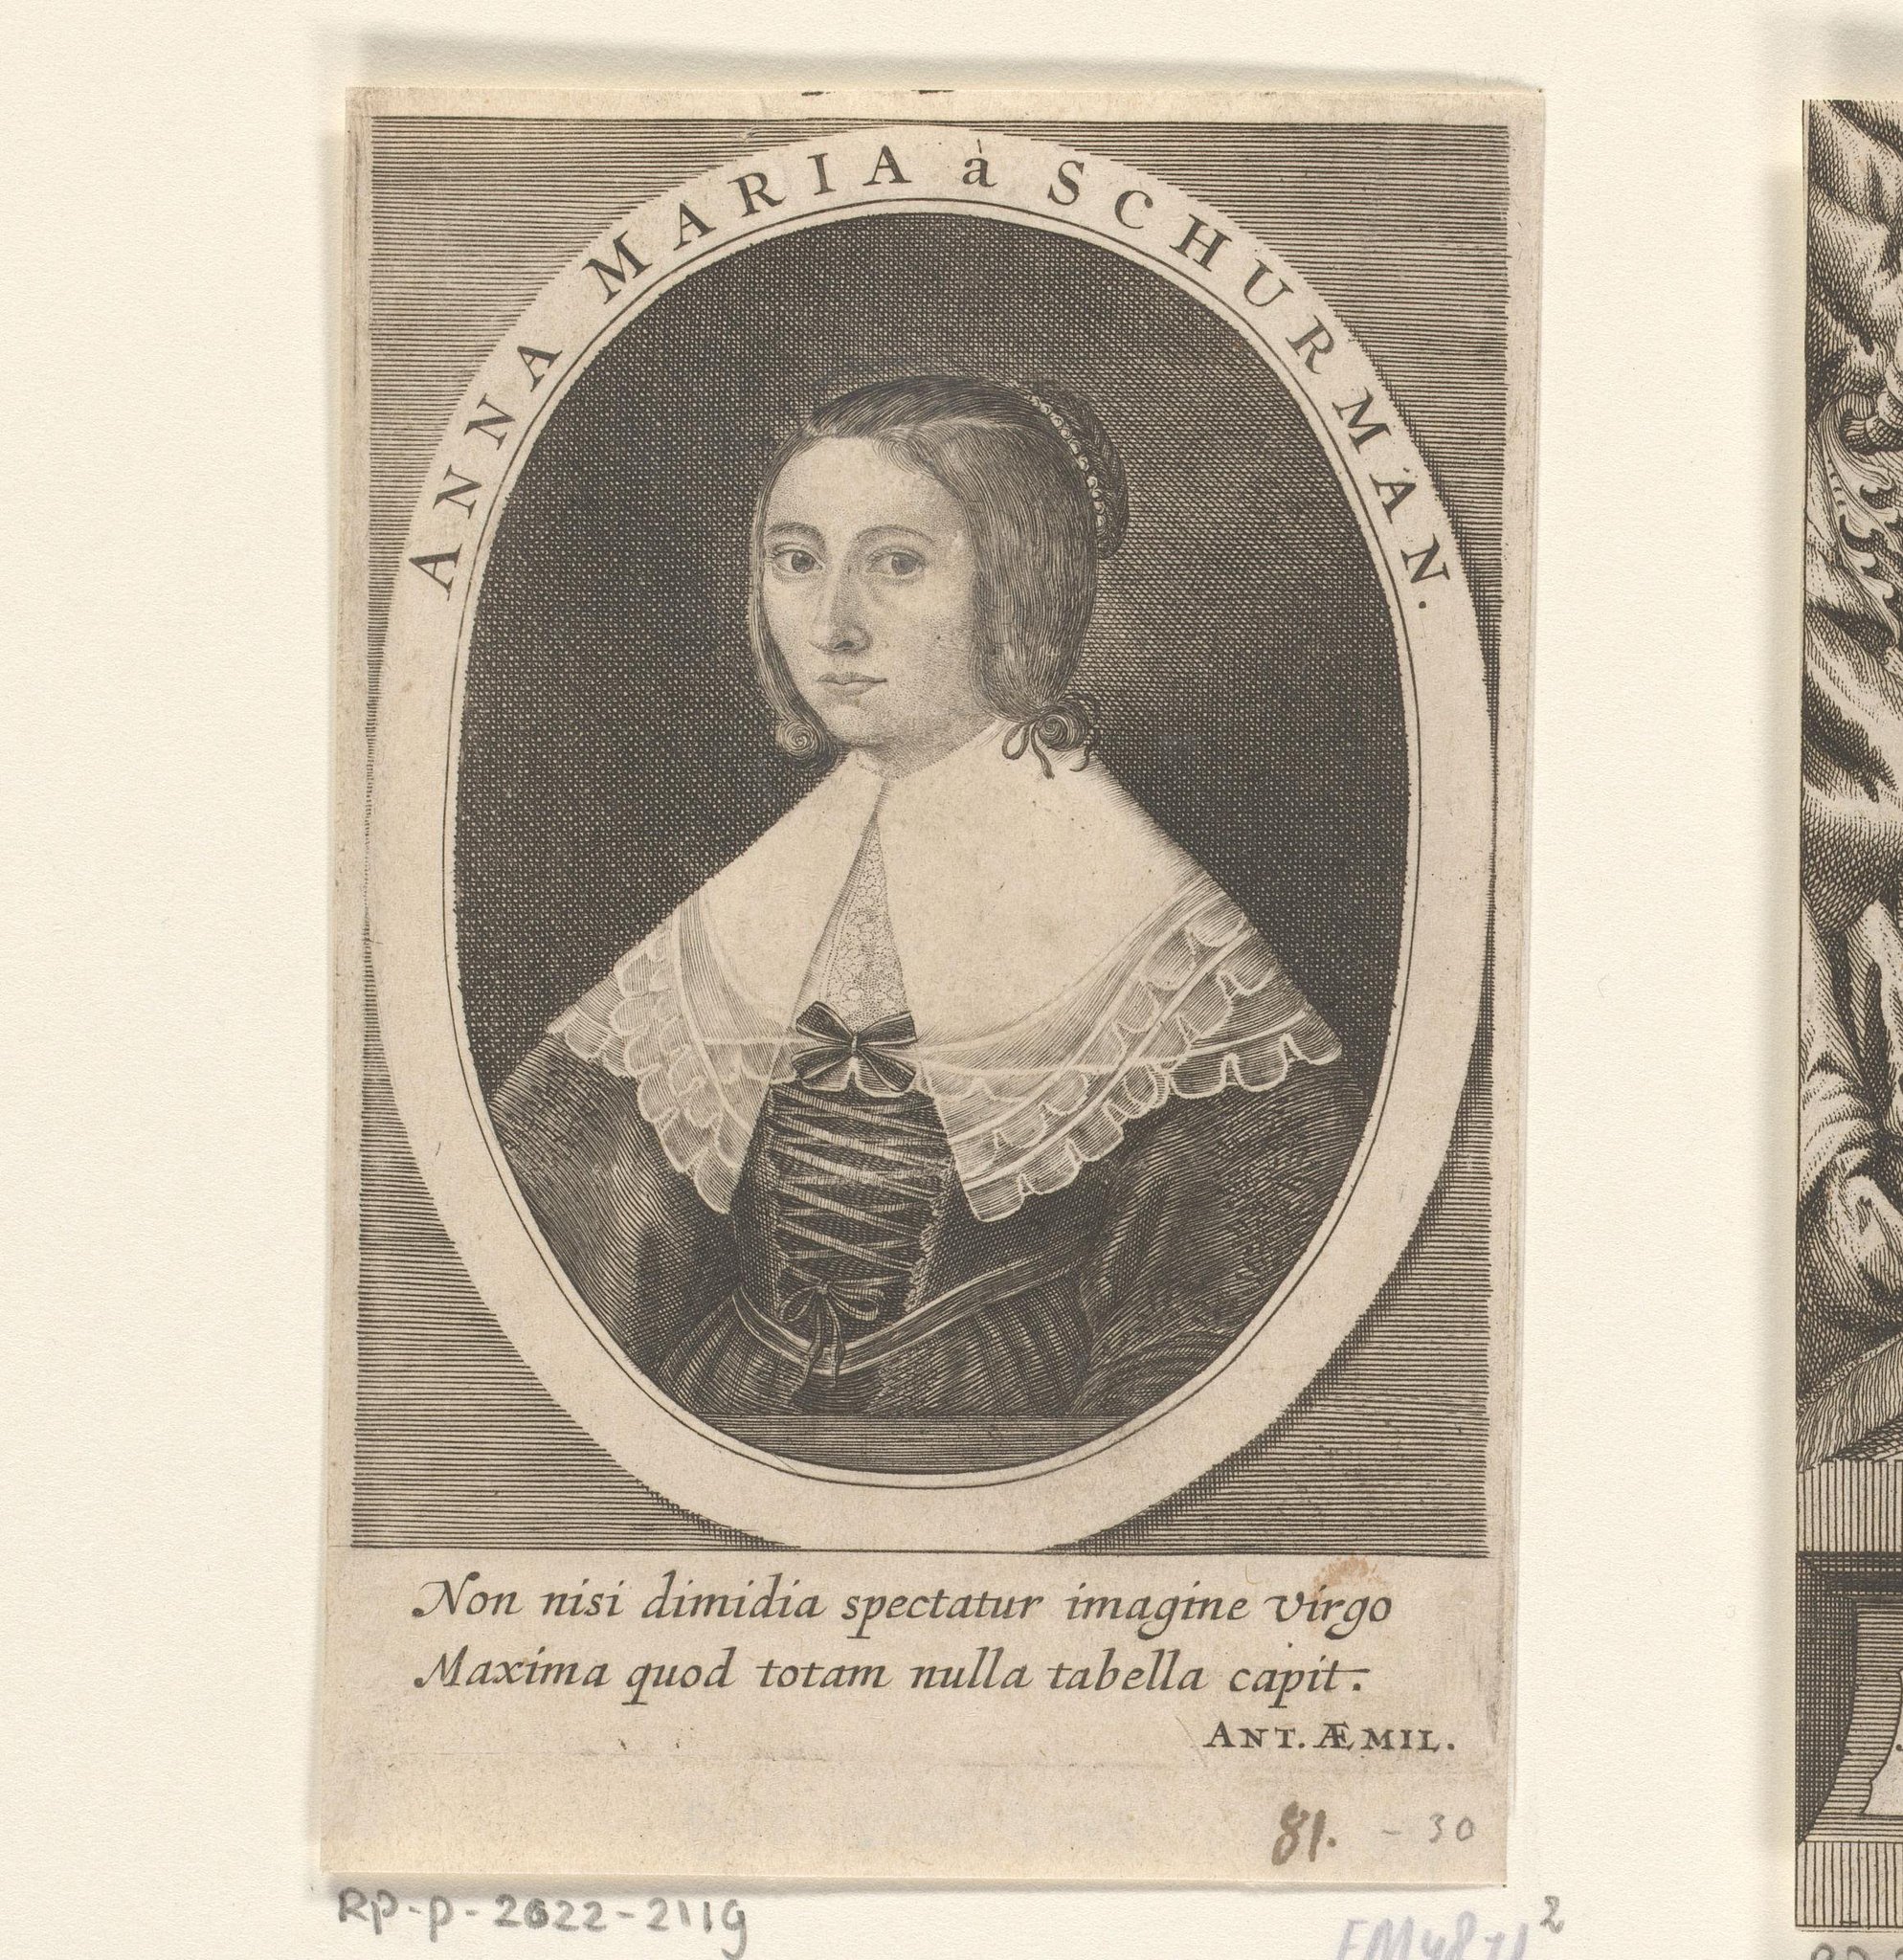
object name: print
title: Portret van Anna Maria van Schurman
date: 1640-1799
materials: paper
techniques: engraving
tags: print maker, draughtsman, anna maria van schurman, historical persons - bb - woman, portrait, self-portrait of artist, writer, poet, author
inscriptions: number: ‘81’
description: Met tweeregelig onderschrift in het Latijn.